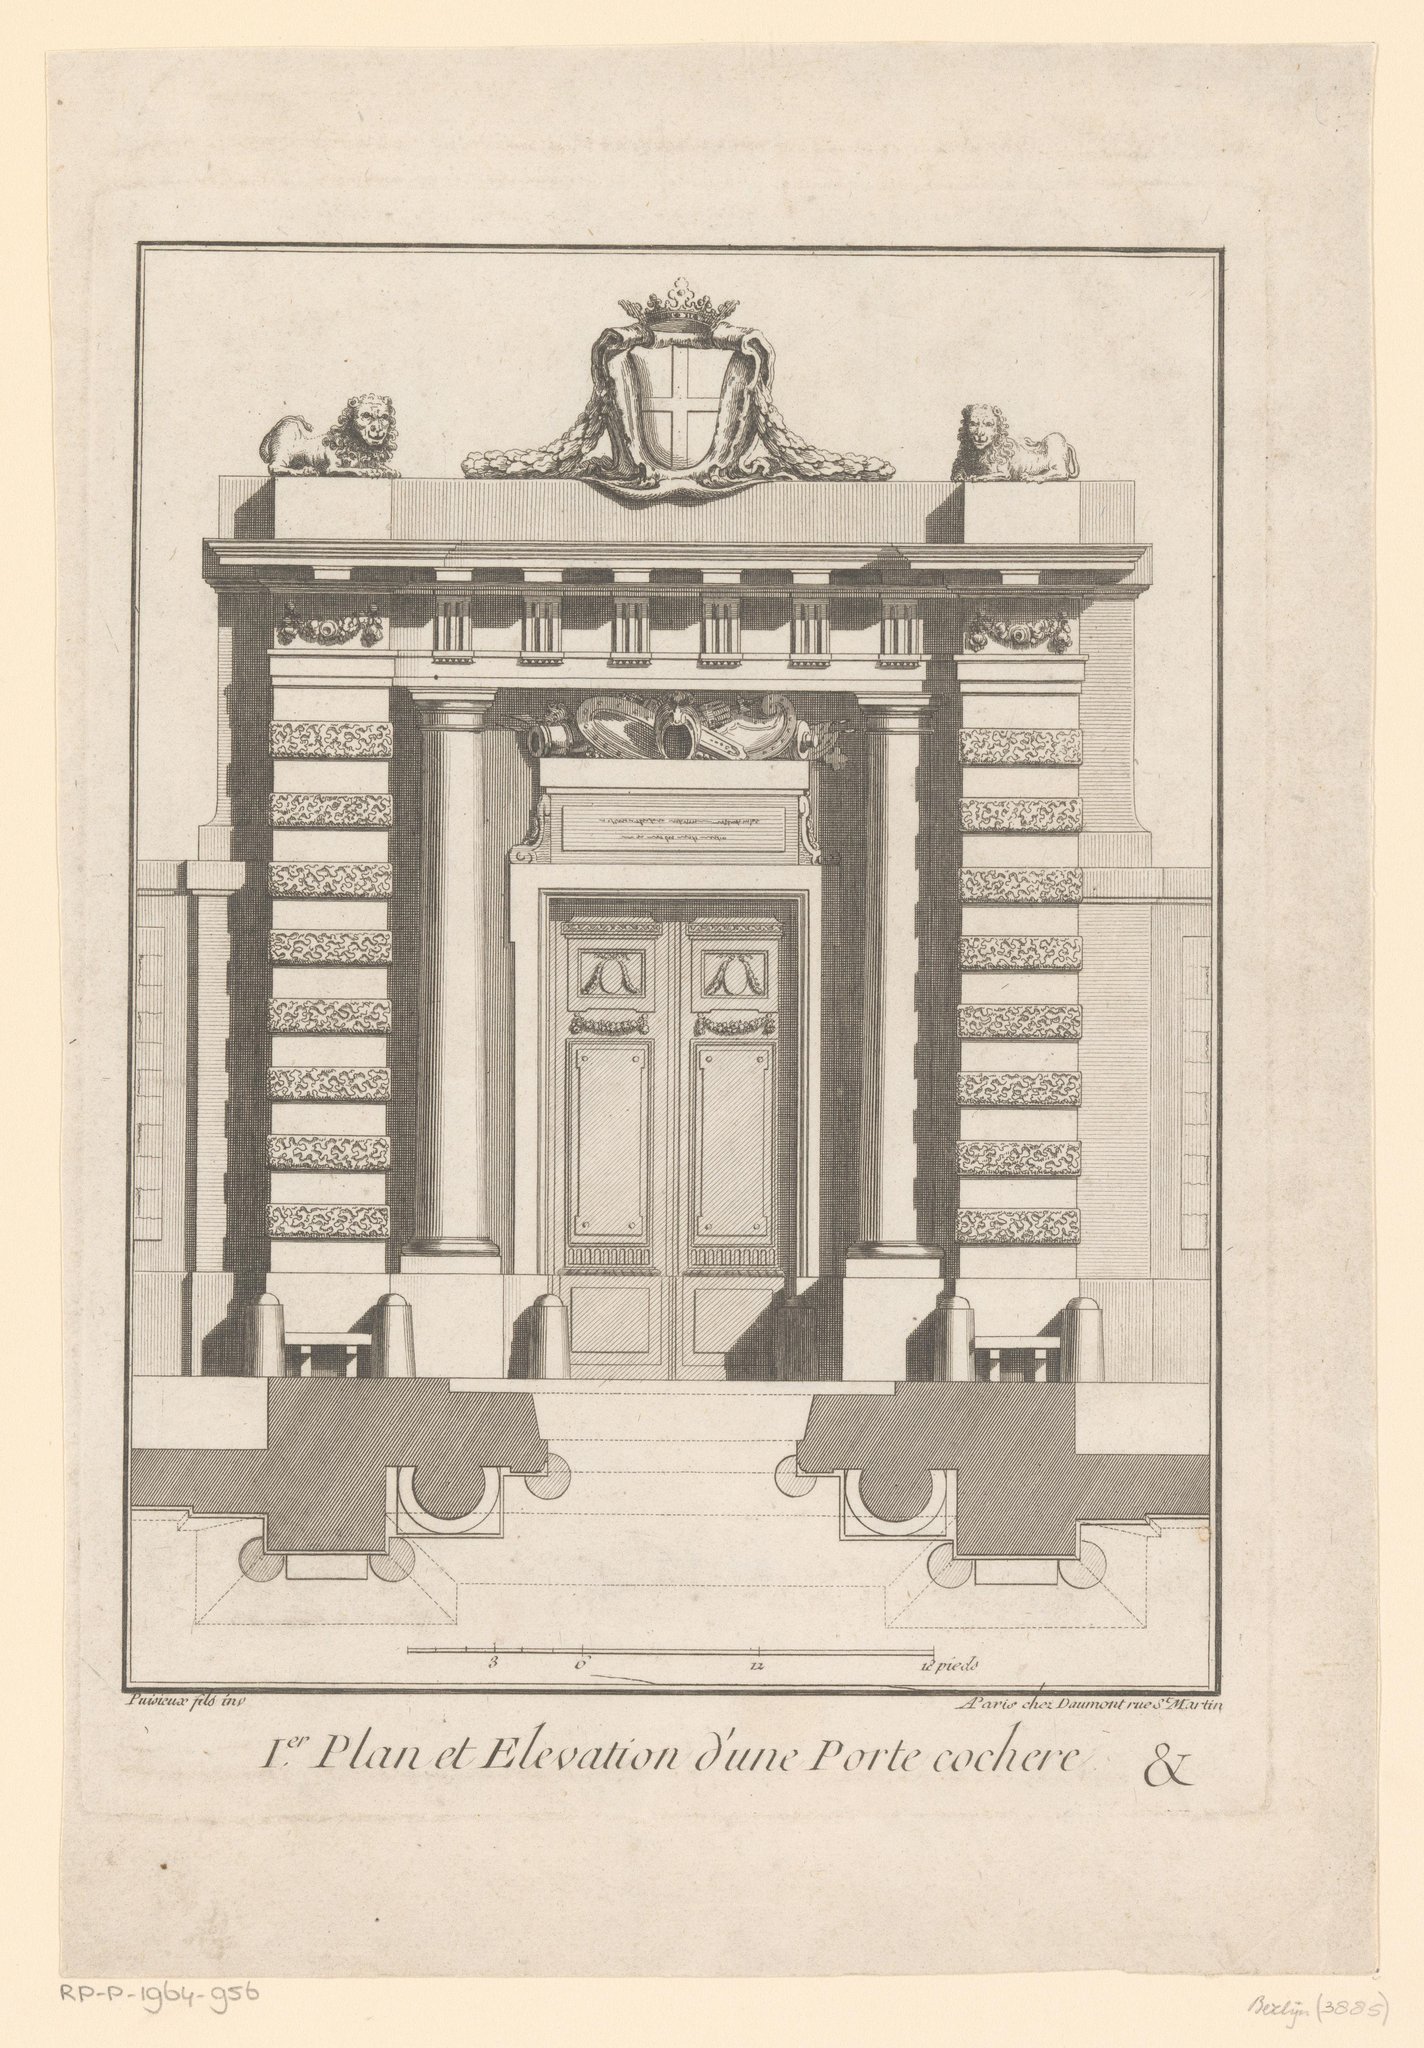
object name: titelprent, frontispice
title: Poort met wapenschild en leeuwen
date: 1745-1775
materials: paper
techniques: engraving, etching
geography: paris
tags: monumental door, porch, 'aediculum', beasts of prey, predatory animals: lion, armorial bearing, heraldry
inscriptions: collector's mark: Lugt 2760, collector's mark: Lugt 2228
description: Vooraanzicht en plattegrond van een koetspoort met zuilen, een helm, schilden en wapens. Boven de poort een gekroond rocaille wapenschild geflankeerd door leeuwen.